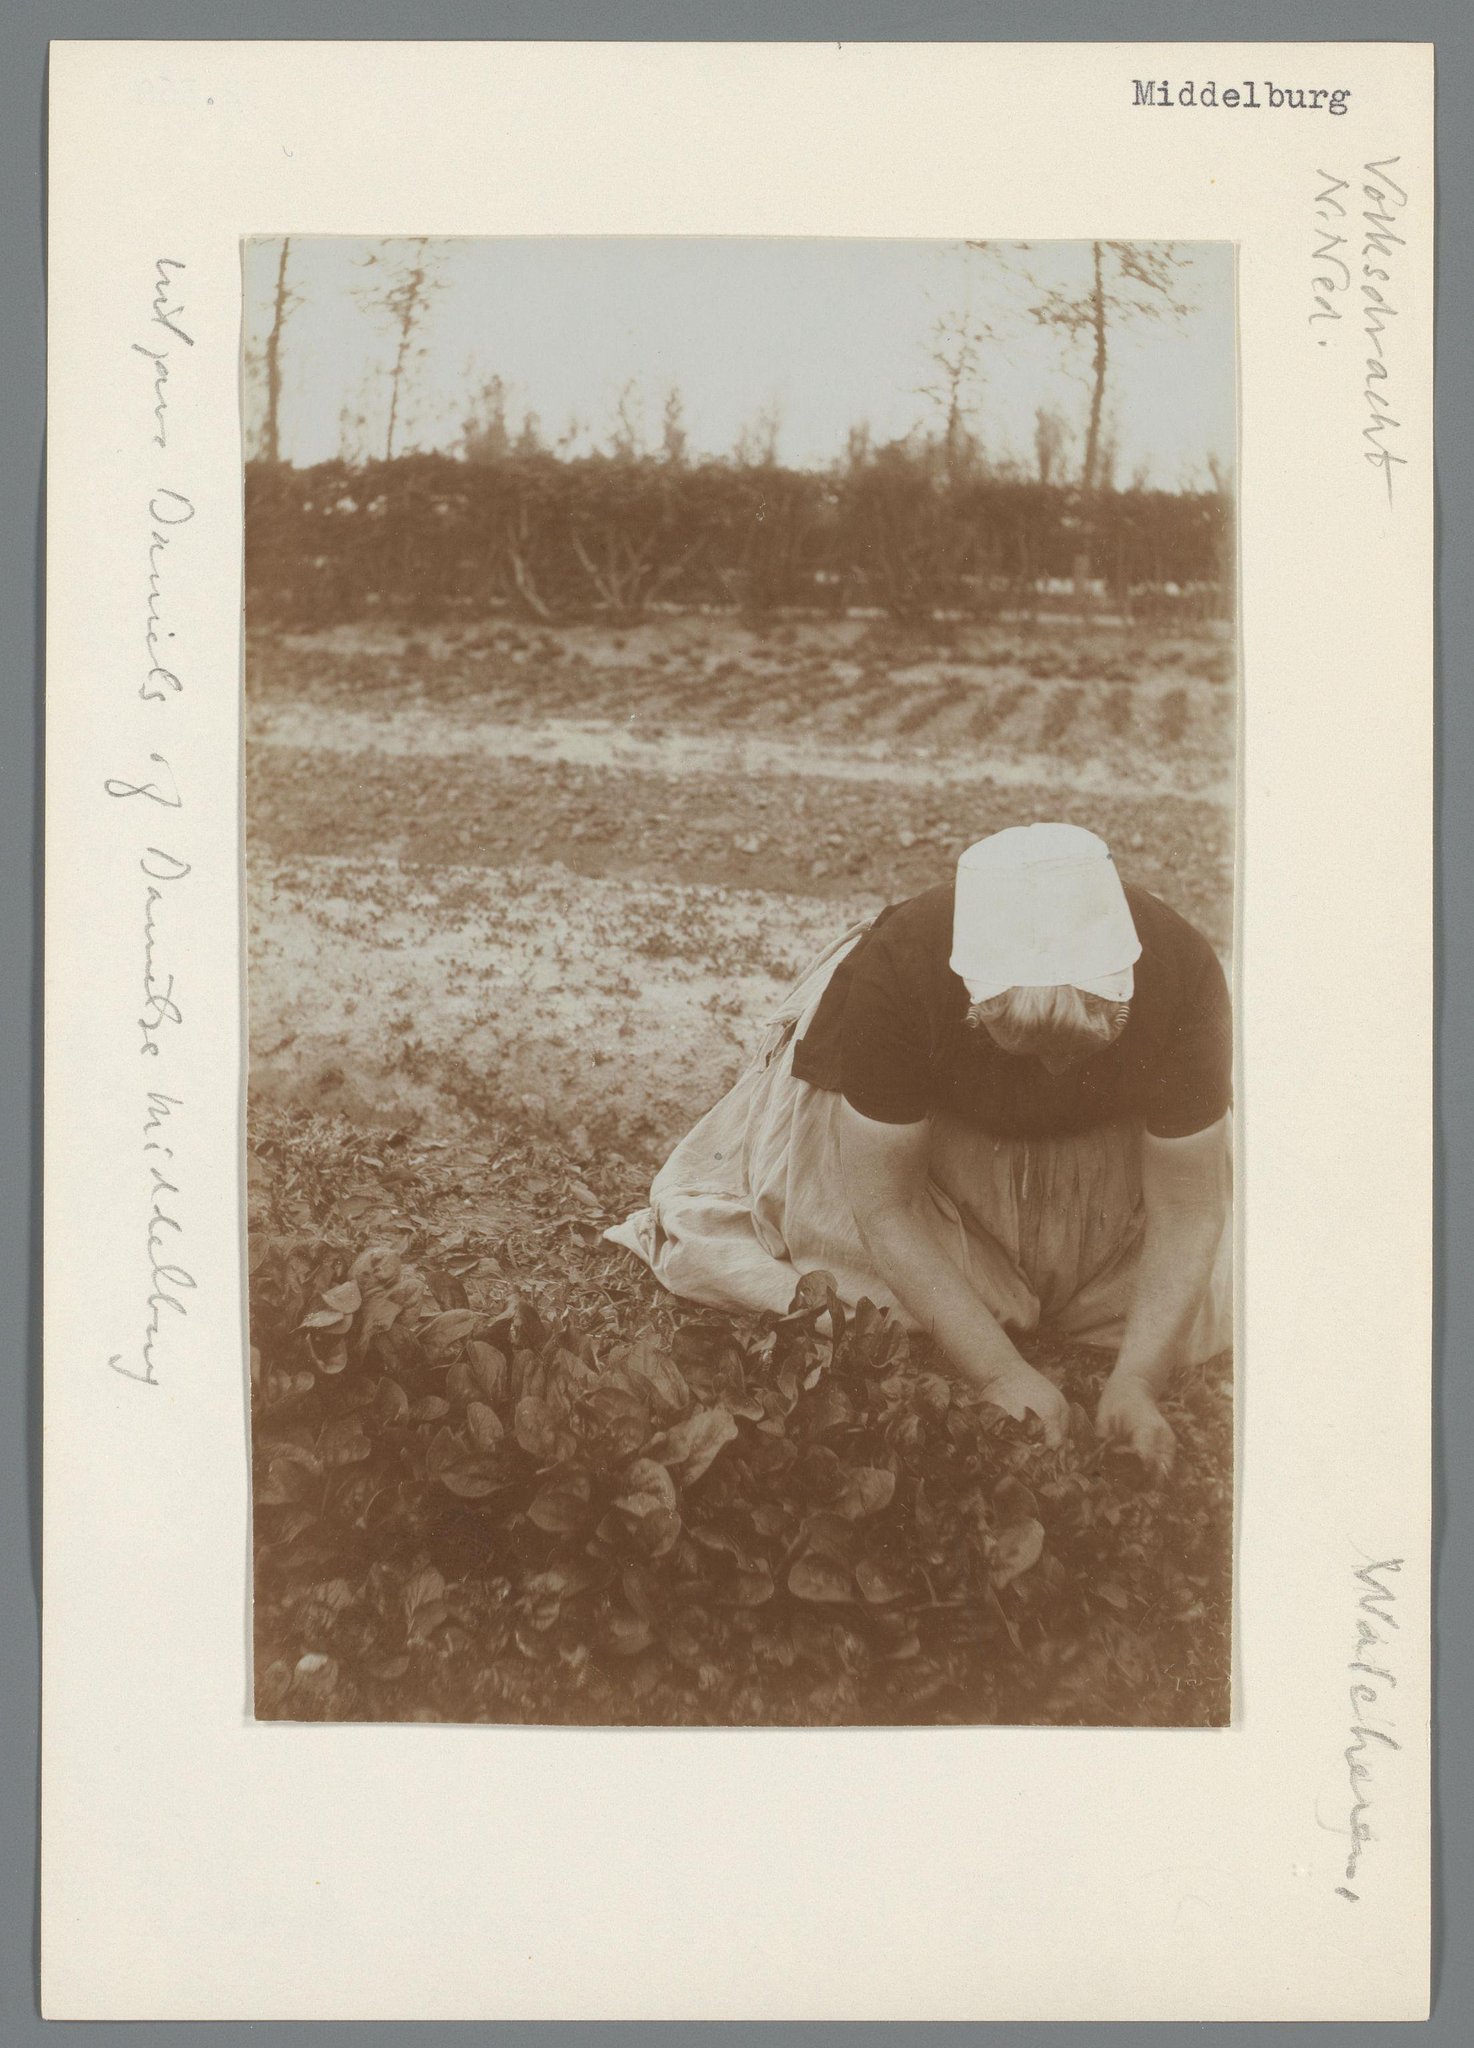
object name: photograph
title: Middelburg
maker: Anonymous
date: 1880-1920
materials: paper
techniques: collodion silver print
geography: walcheren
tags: historical persons - bb - woman, folk costume, regional costume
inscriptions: inscription: ‘uitgave Daniels of Danielse Middelburg’, inscription: ‘Volksdracht/ N.Ned./ Walcheren’, number: ‘- 5270 44’, number: ‘32.368’